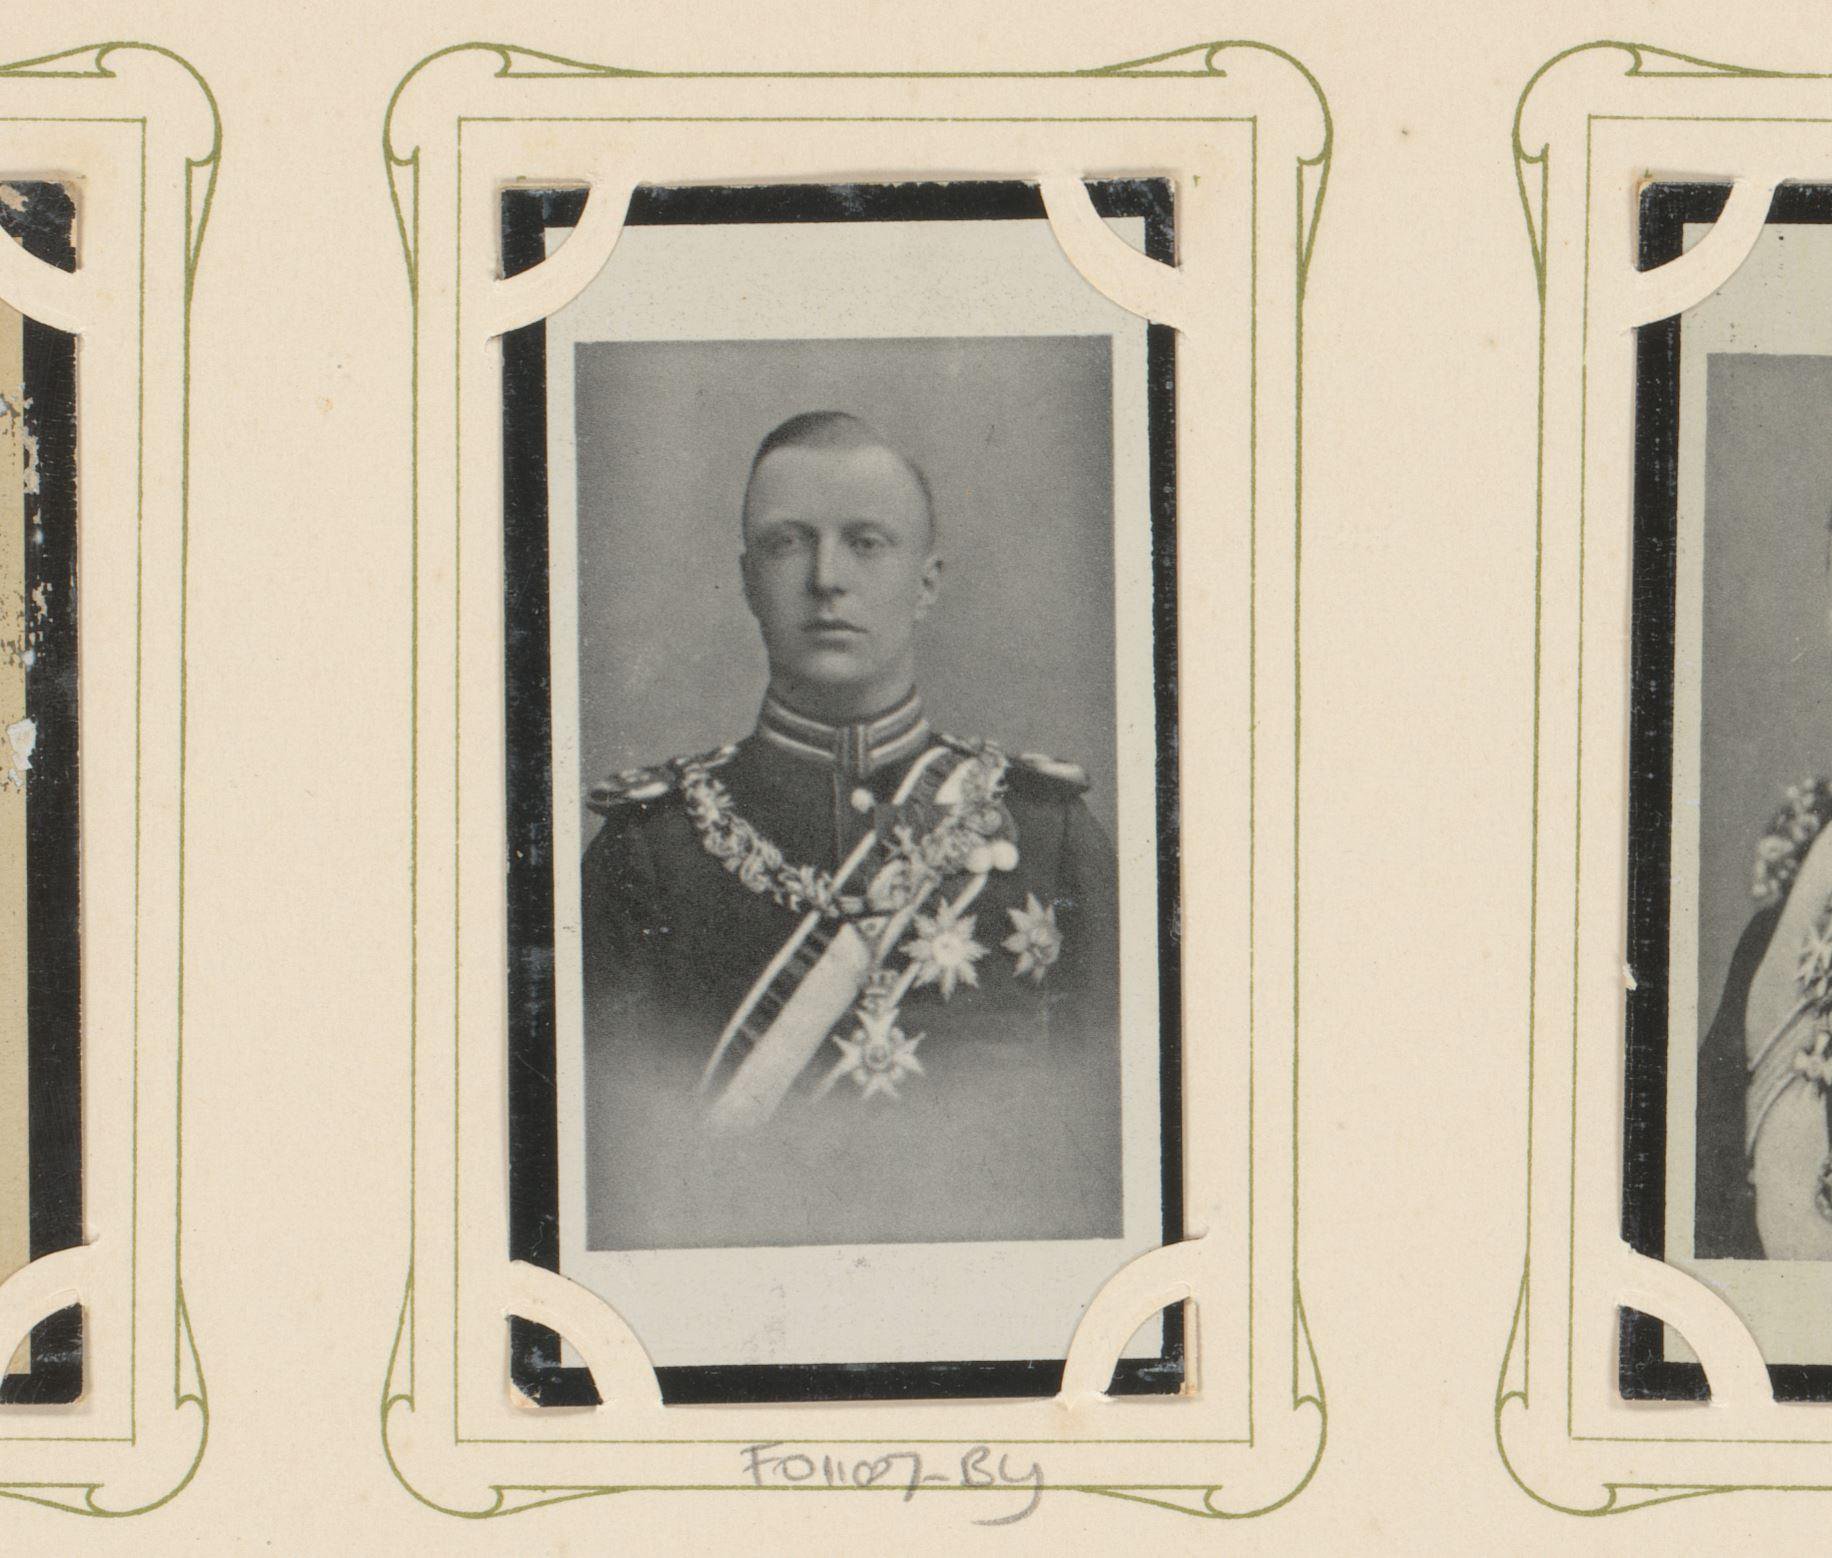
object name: album leaf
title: Portret van Hendrik, prins der Nederlanden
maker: Anonymous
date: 1905-1906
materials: paper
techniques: photograph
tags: the hague, hendrik (prins der nederlanden (1876-1934)), historical persons - bb - woman, prince consort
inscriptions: inscription: ‘No. 2./ Prins Hendrik der Nederlanden.’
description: Deze prent maakt deel uit van een album.